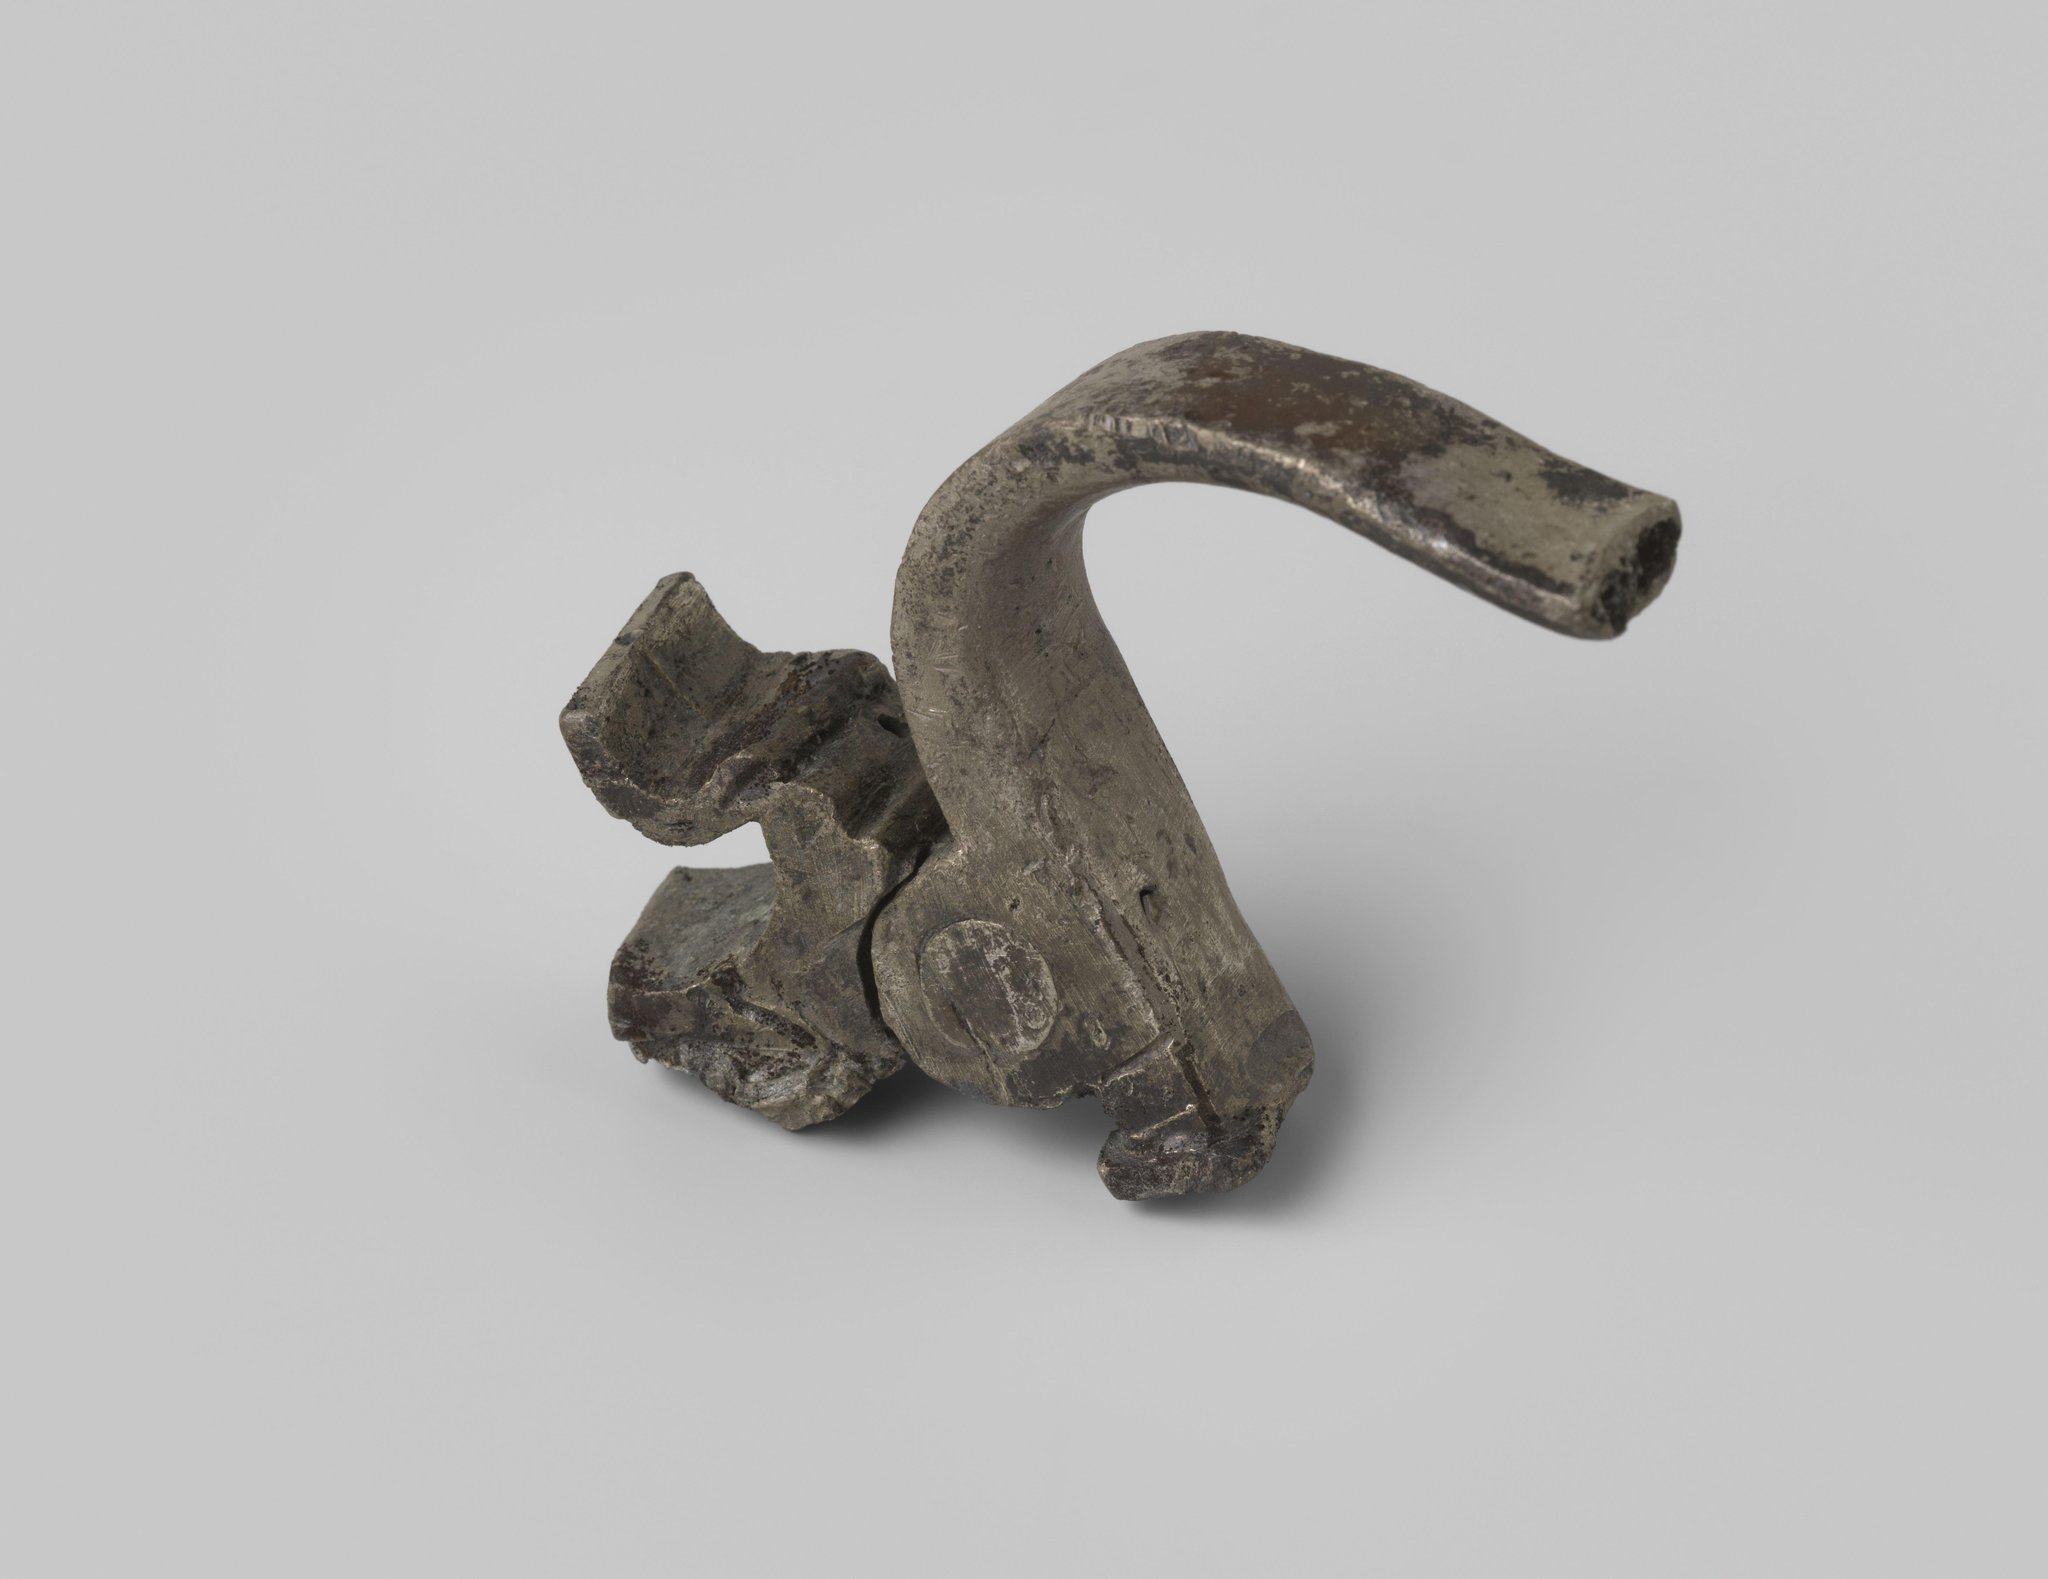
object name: lug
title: Oor van een kan uit het wrak van de Oost-Indiëvaarder Hollandia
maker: Anonymous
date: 1700-1743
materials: tin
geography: netherlands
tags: verenigde oostindische compagnie, hollandia (schip), annet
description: Jug, handle, fragm, lower end broken off; curved strip, semicircular in section, slightly tapering, with double-bladed hinge and curved thumbpiece.